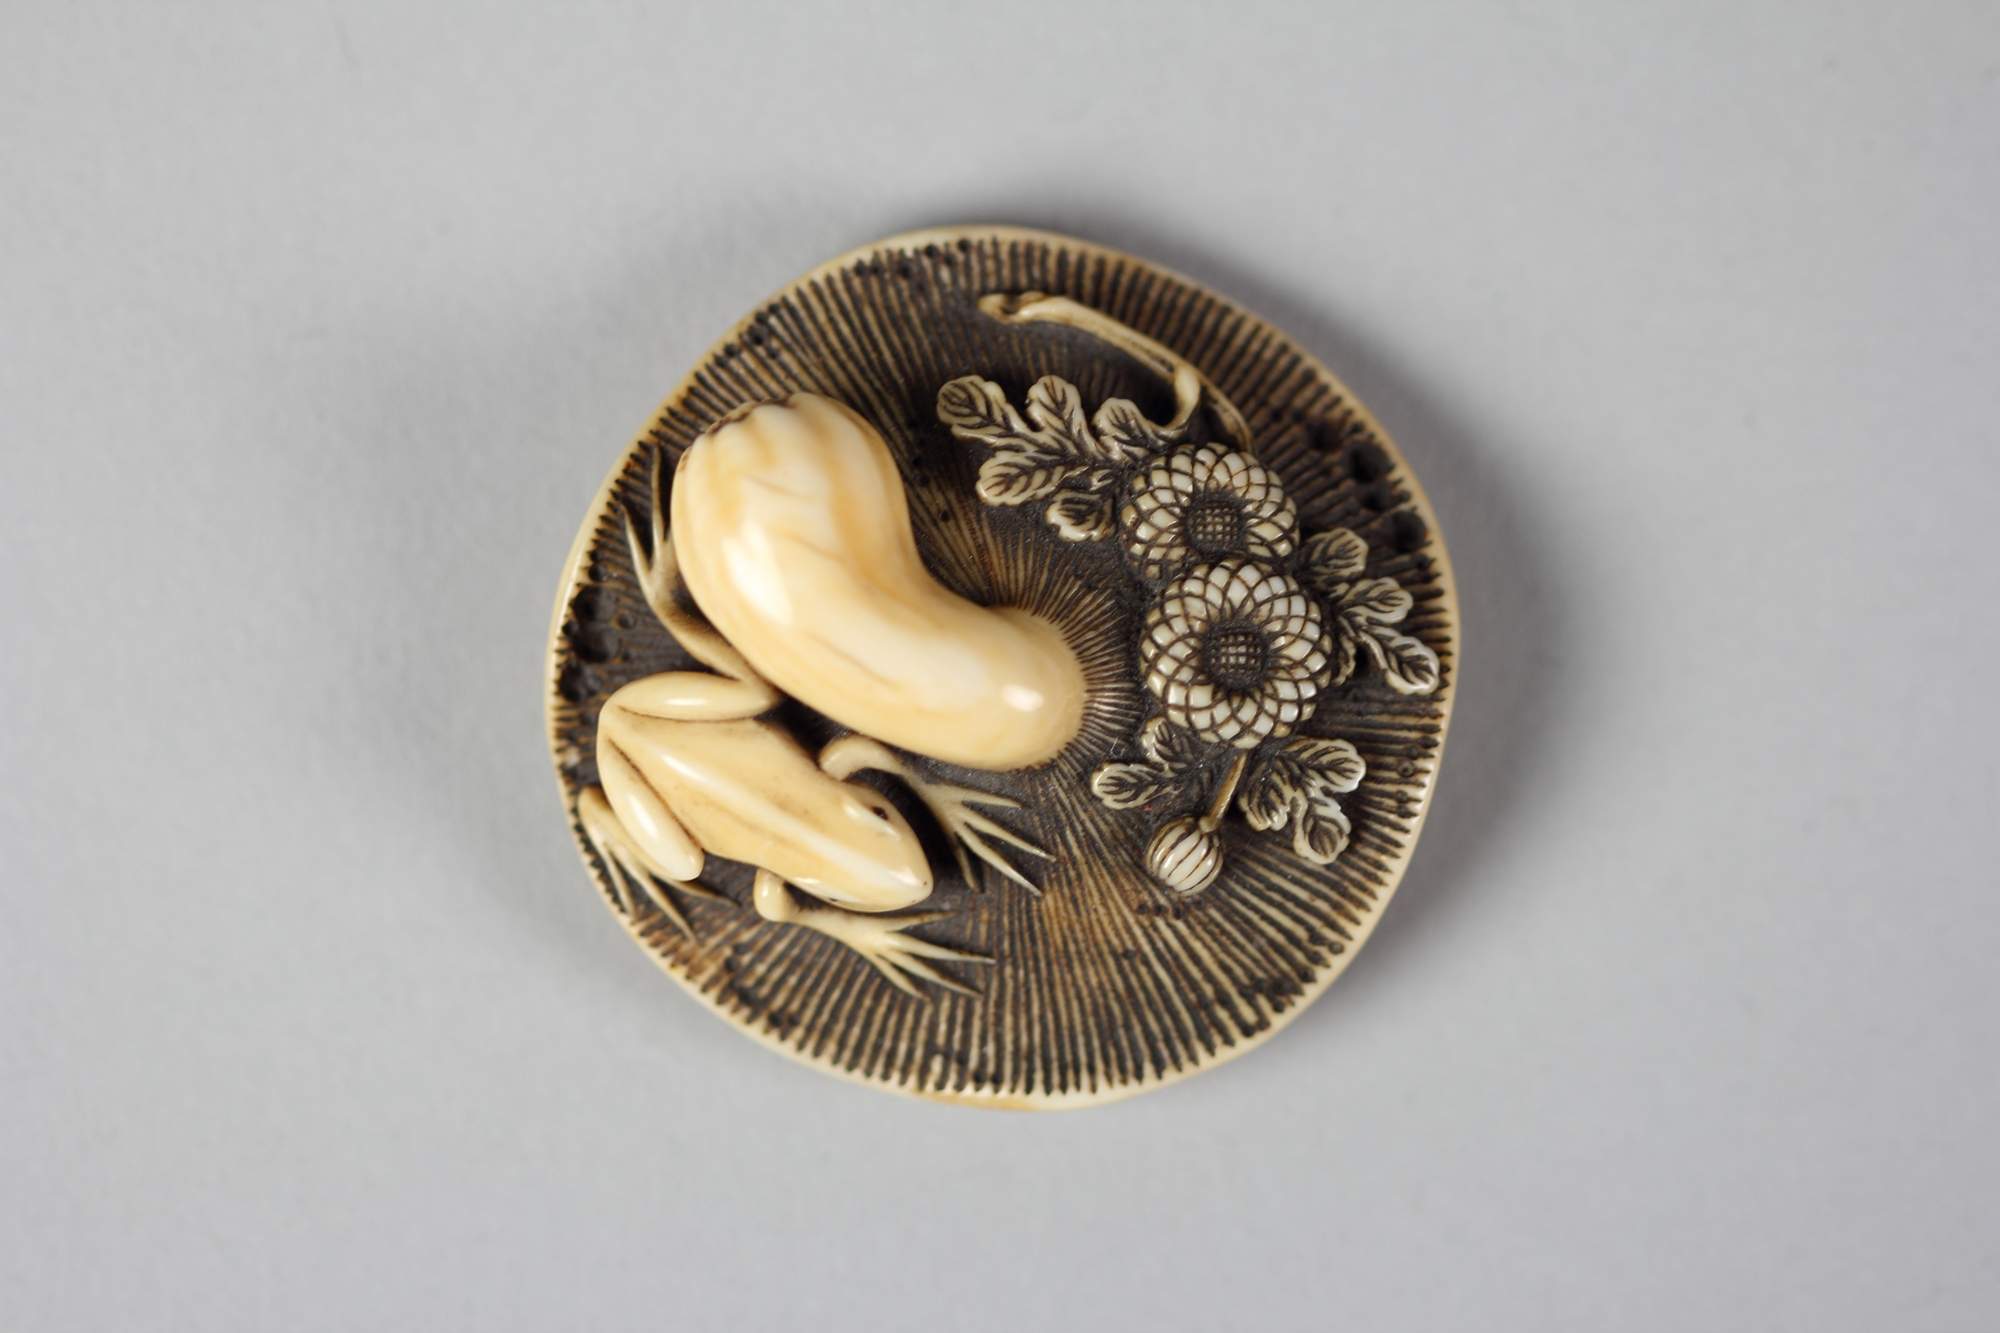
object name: netsuke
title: Netsuke of Mushroom and Frog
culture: japanese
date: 1801-1900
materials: ivory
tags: frogs